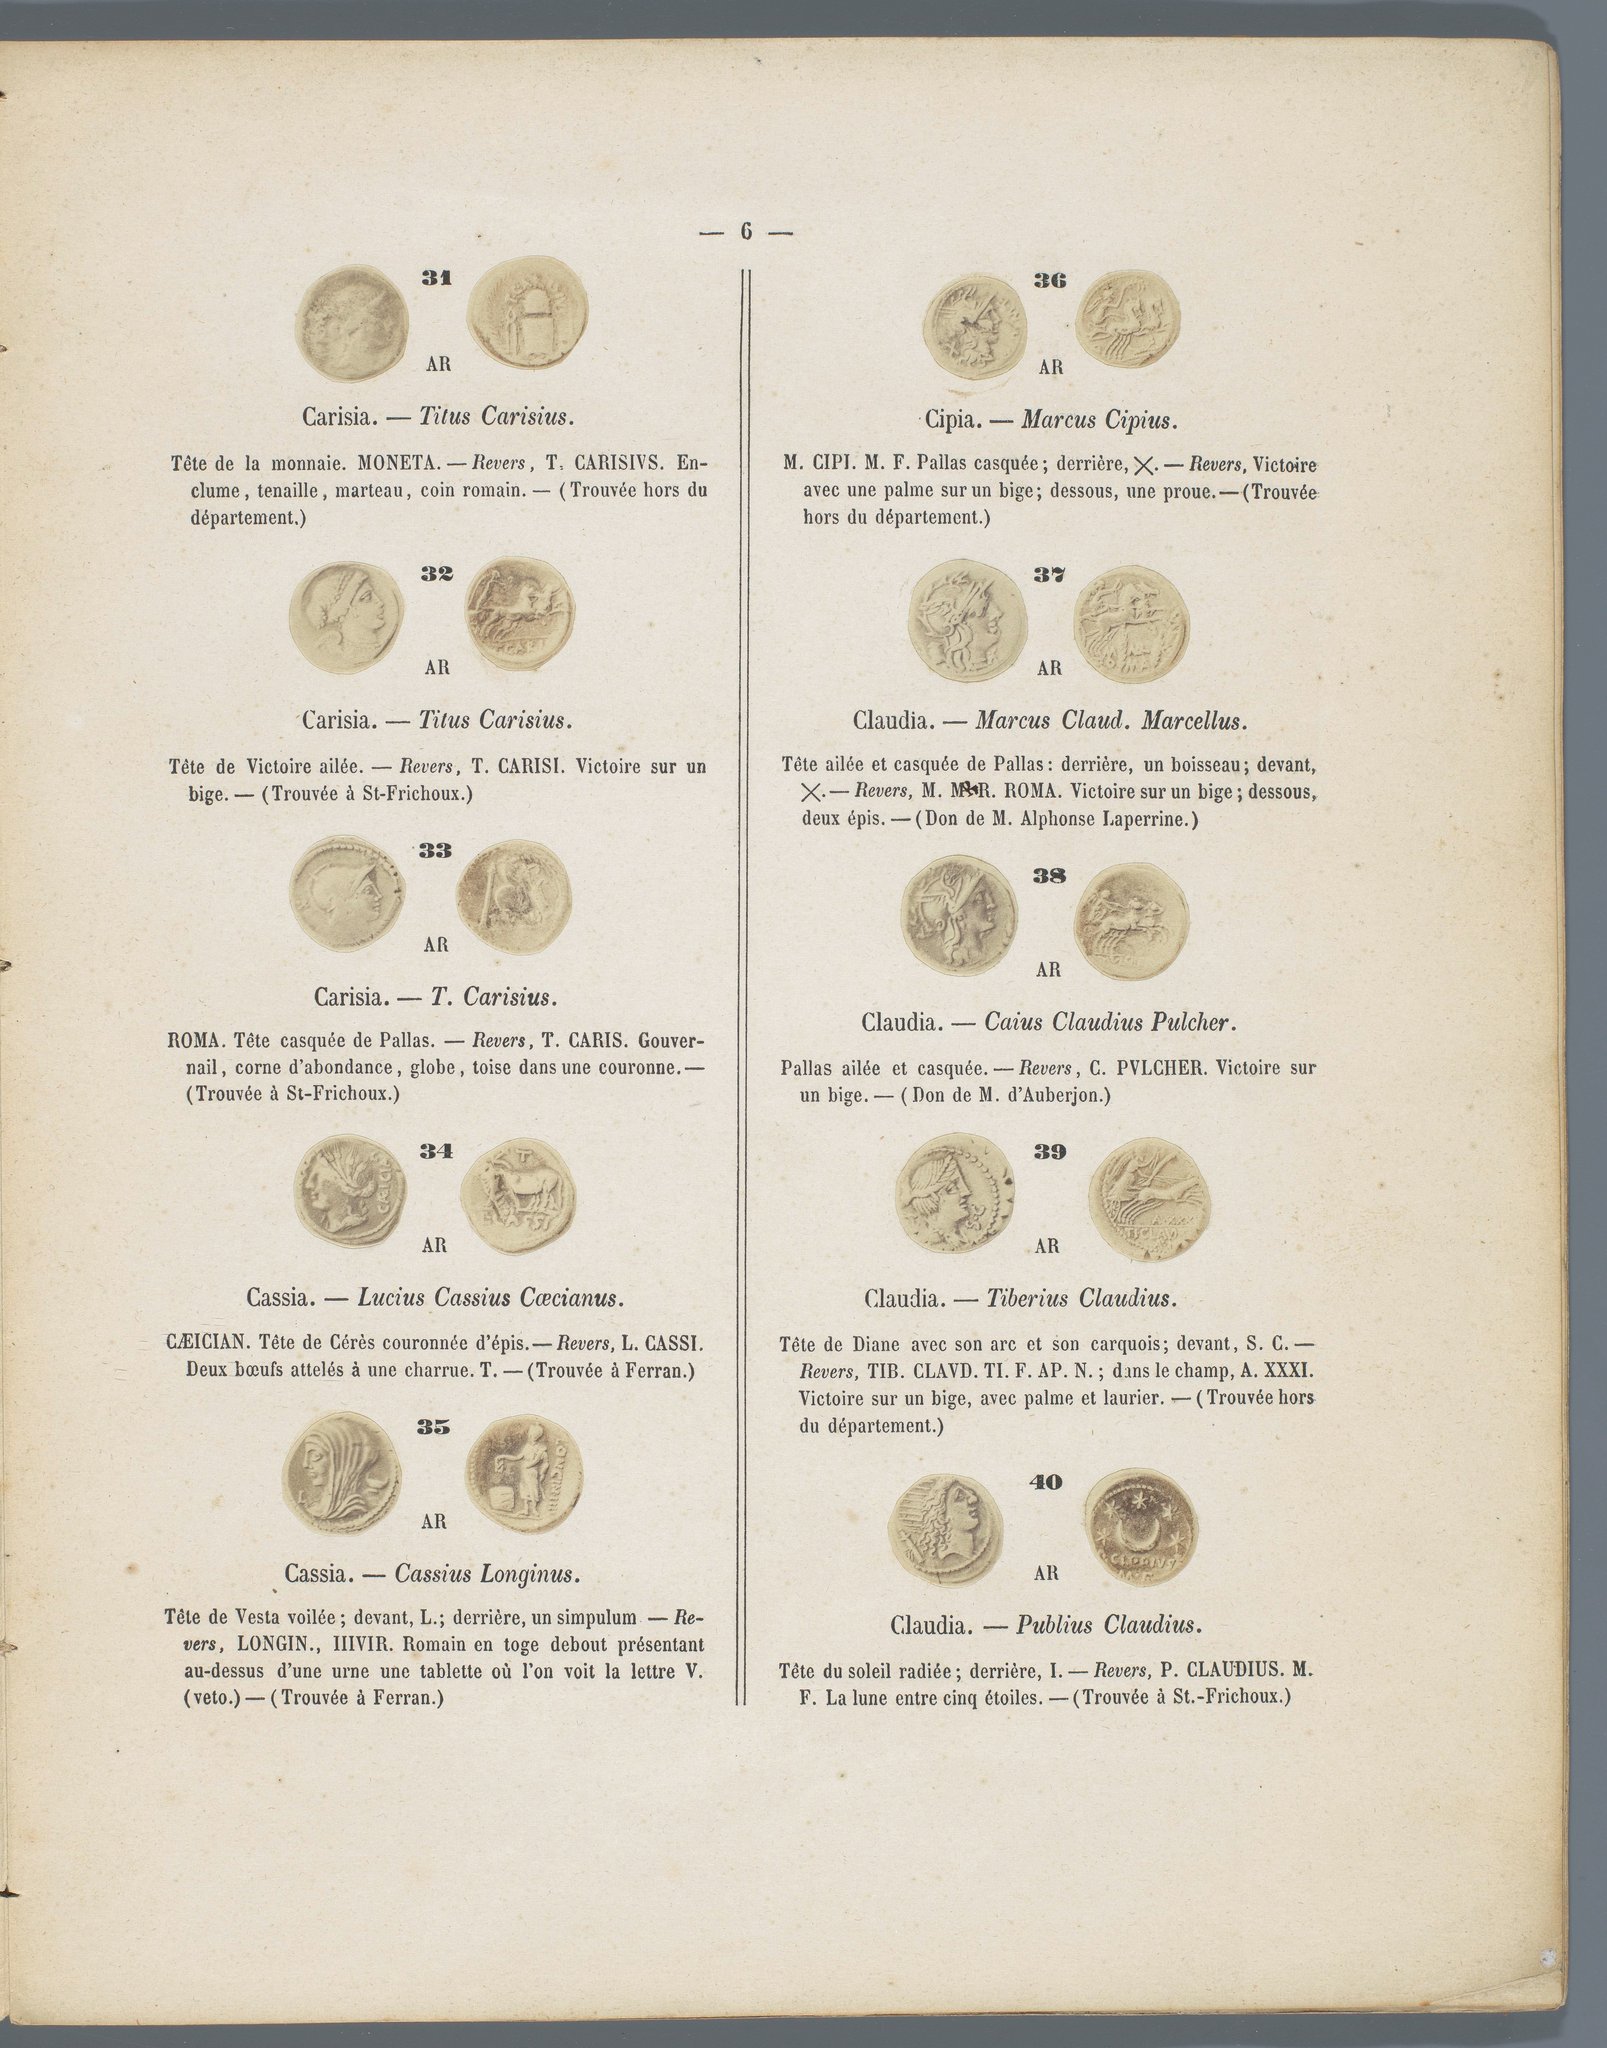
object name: page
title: Tien Romeinse munten, gezien van voor- en achterkant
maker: léopold verguet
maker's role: abt, fotograaf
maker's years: 1817-1914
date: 1854-1864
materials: photographic support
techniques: albumen print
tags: coin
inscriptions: number